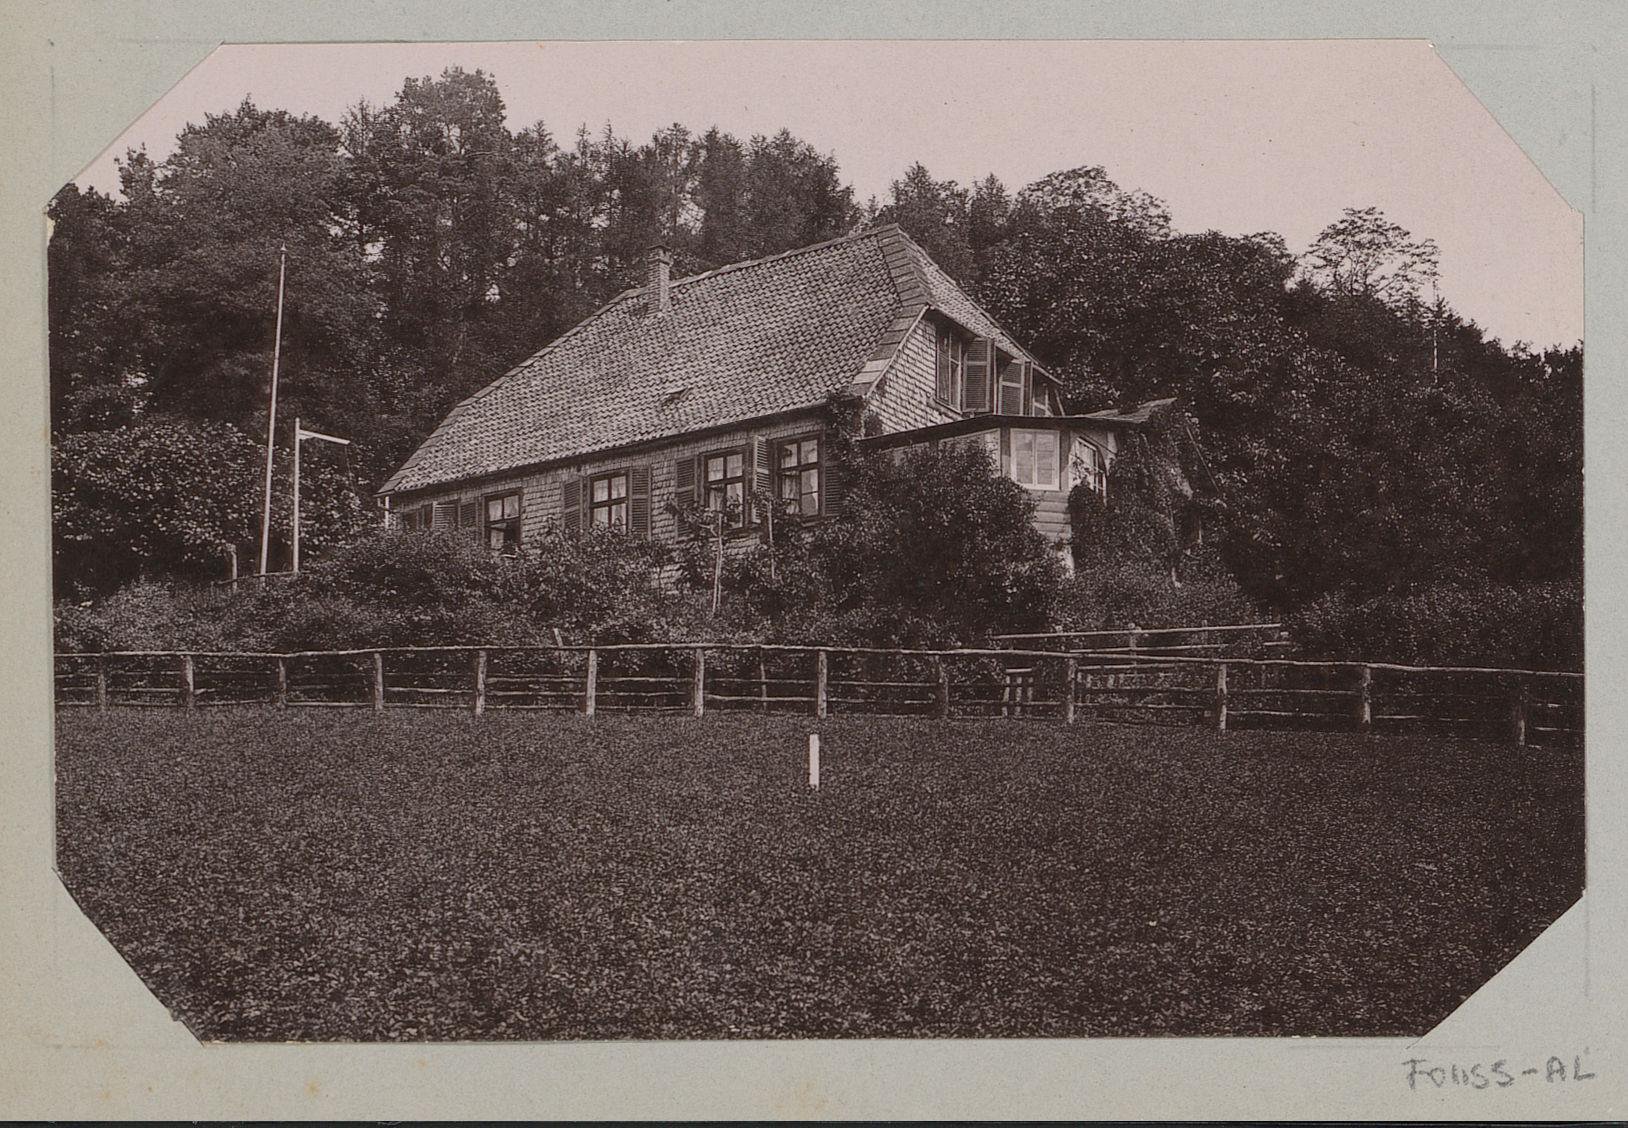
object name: album leaf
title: Woning te Pyrmont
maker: Anonymous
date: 1890-1897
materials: paper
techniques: photograph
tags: rural housing, e.g. country-house, villa, cottage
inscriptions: annotation: ‘Königsberg’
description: Deze prent maakt deel uit van een album.